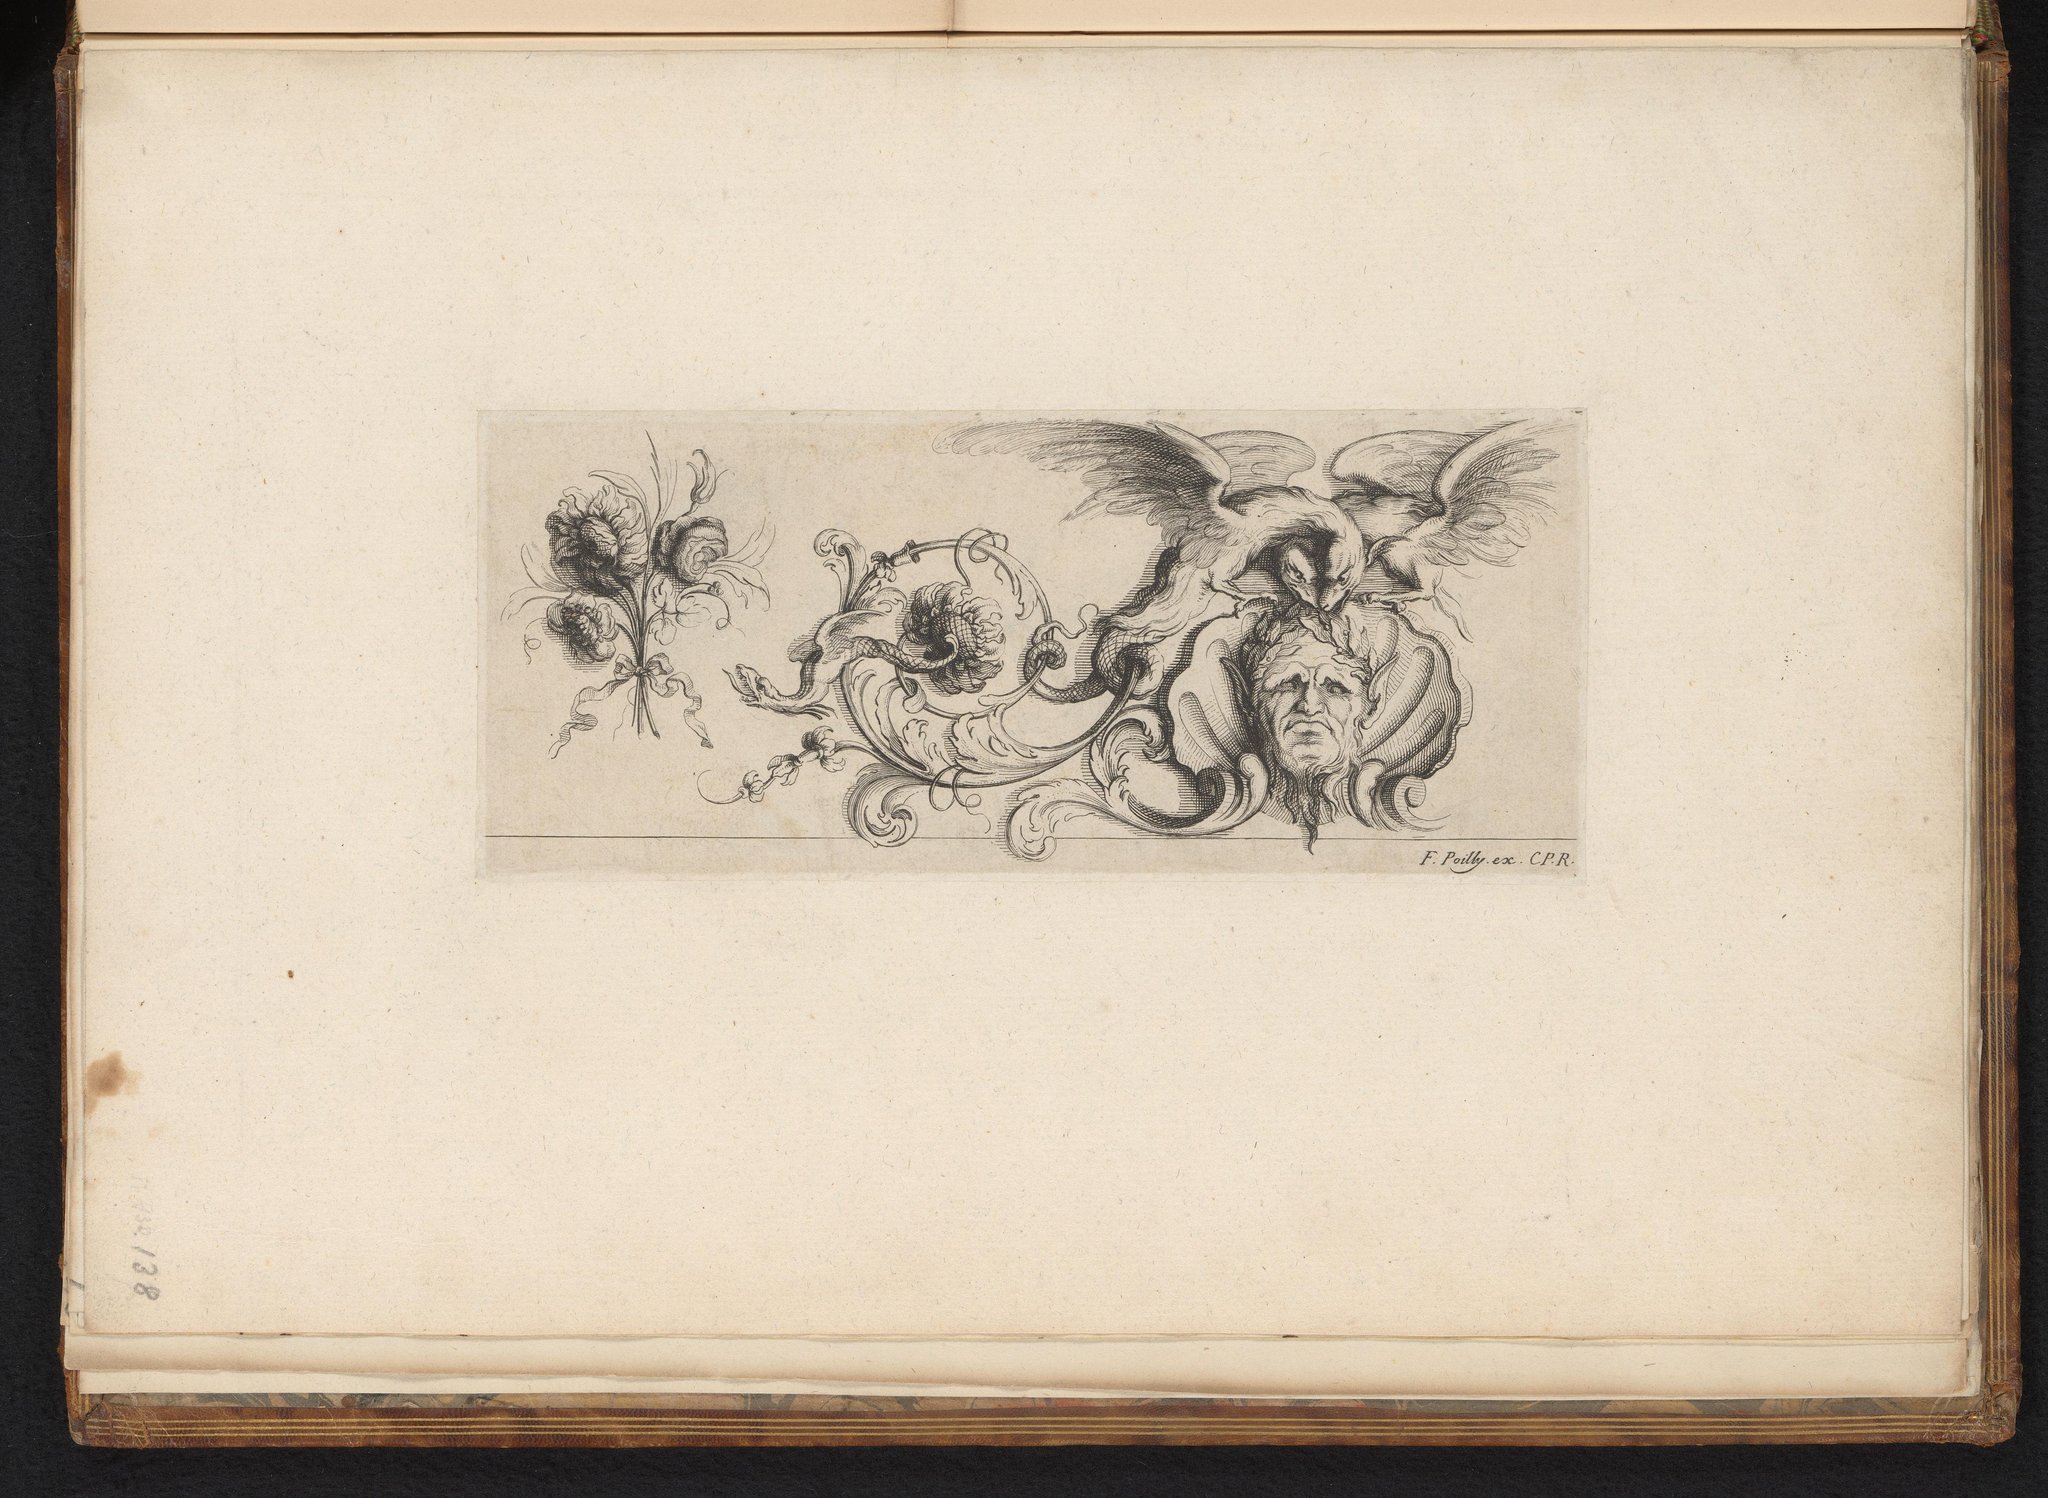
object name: album leaf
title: Friezen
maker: Anonymous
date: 1682-1723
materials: paper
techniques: etching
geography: france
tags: ornament ~ grotesque, ornament ~ arabesque, satyr(s) (in general)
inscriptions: collector's mark: Lugt 2760, collector's mark: Lugt 2228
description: Prent maakt deel uit van een serie van zes prenten.